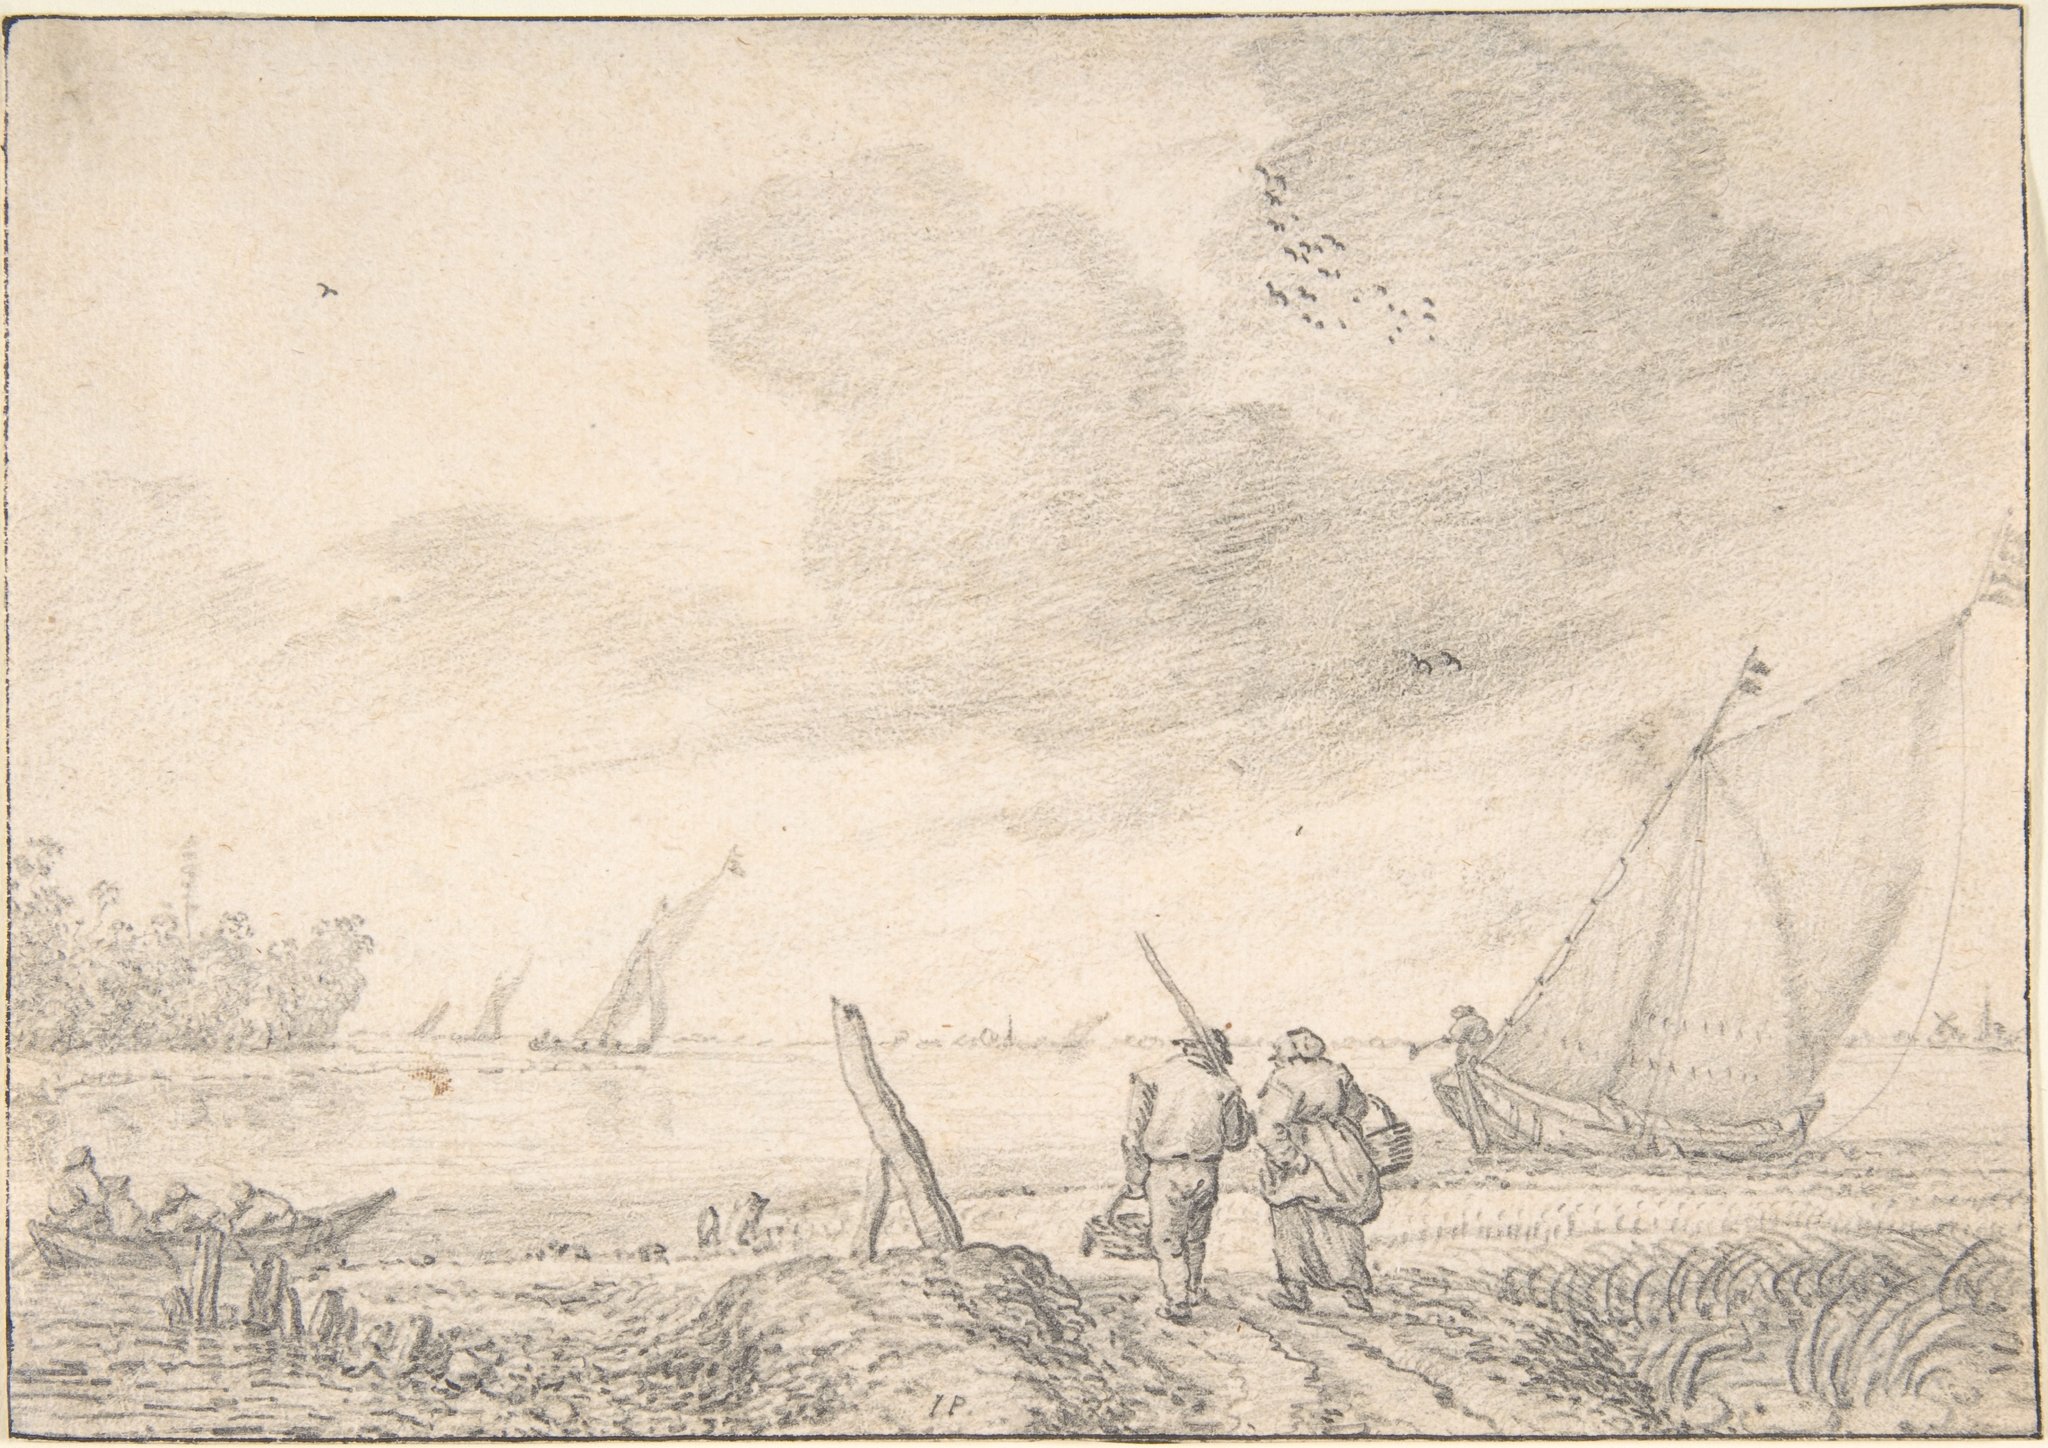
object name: drawing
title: River Landscape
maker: jan porcellis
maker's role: artist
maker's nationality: dutch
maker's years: 1584-1632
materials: chalk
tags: human figures,rivers,landscapes,boats